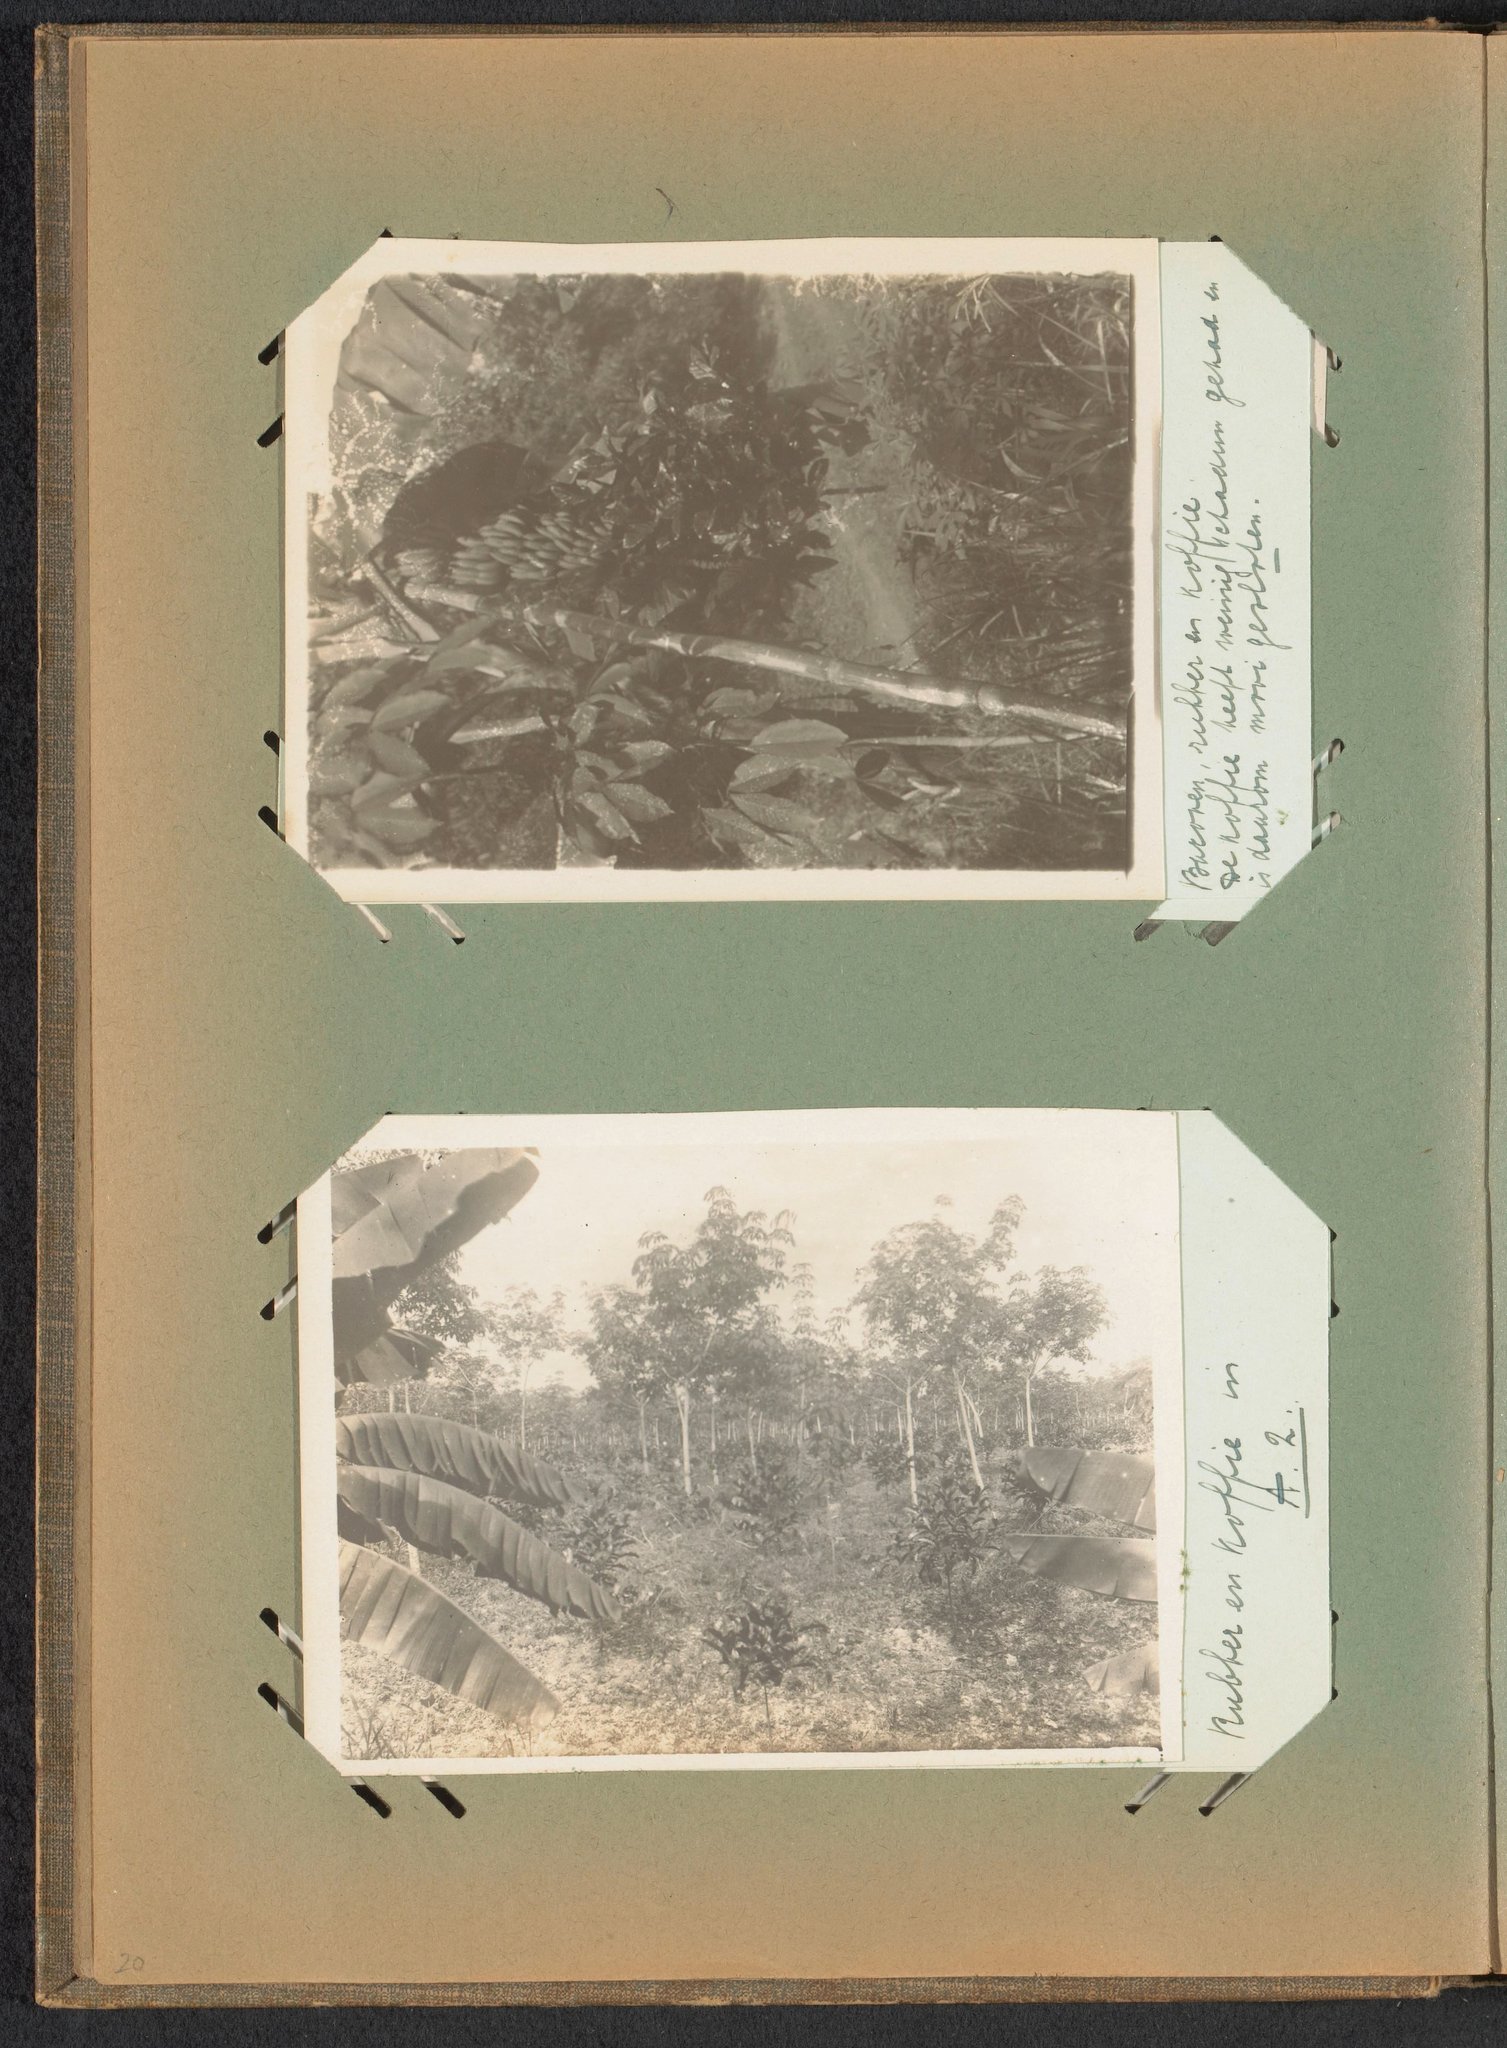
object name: photograph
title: Rubber- en koffiebomen op Plantage Peperpot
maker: Anonymous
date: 1912-1913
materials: paper, photographic support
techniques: gelatin silver print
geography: suriname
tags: plantation, (non-fruit) products of plants or trees: rubber, fruits: coffee, suriname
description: Rubber- en koffiebomen op Plantage Peperpot Suriname. Onderdeel van het fotoalbum uit ca. 1912-1913 met 92 foto's van de plantages Peperpot en Dordrecht in Suriname en Mount Pleasant op Curaçao.